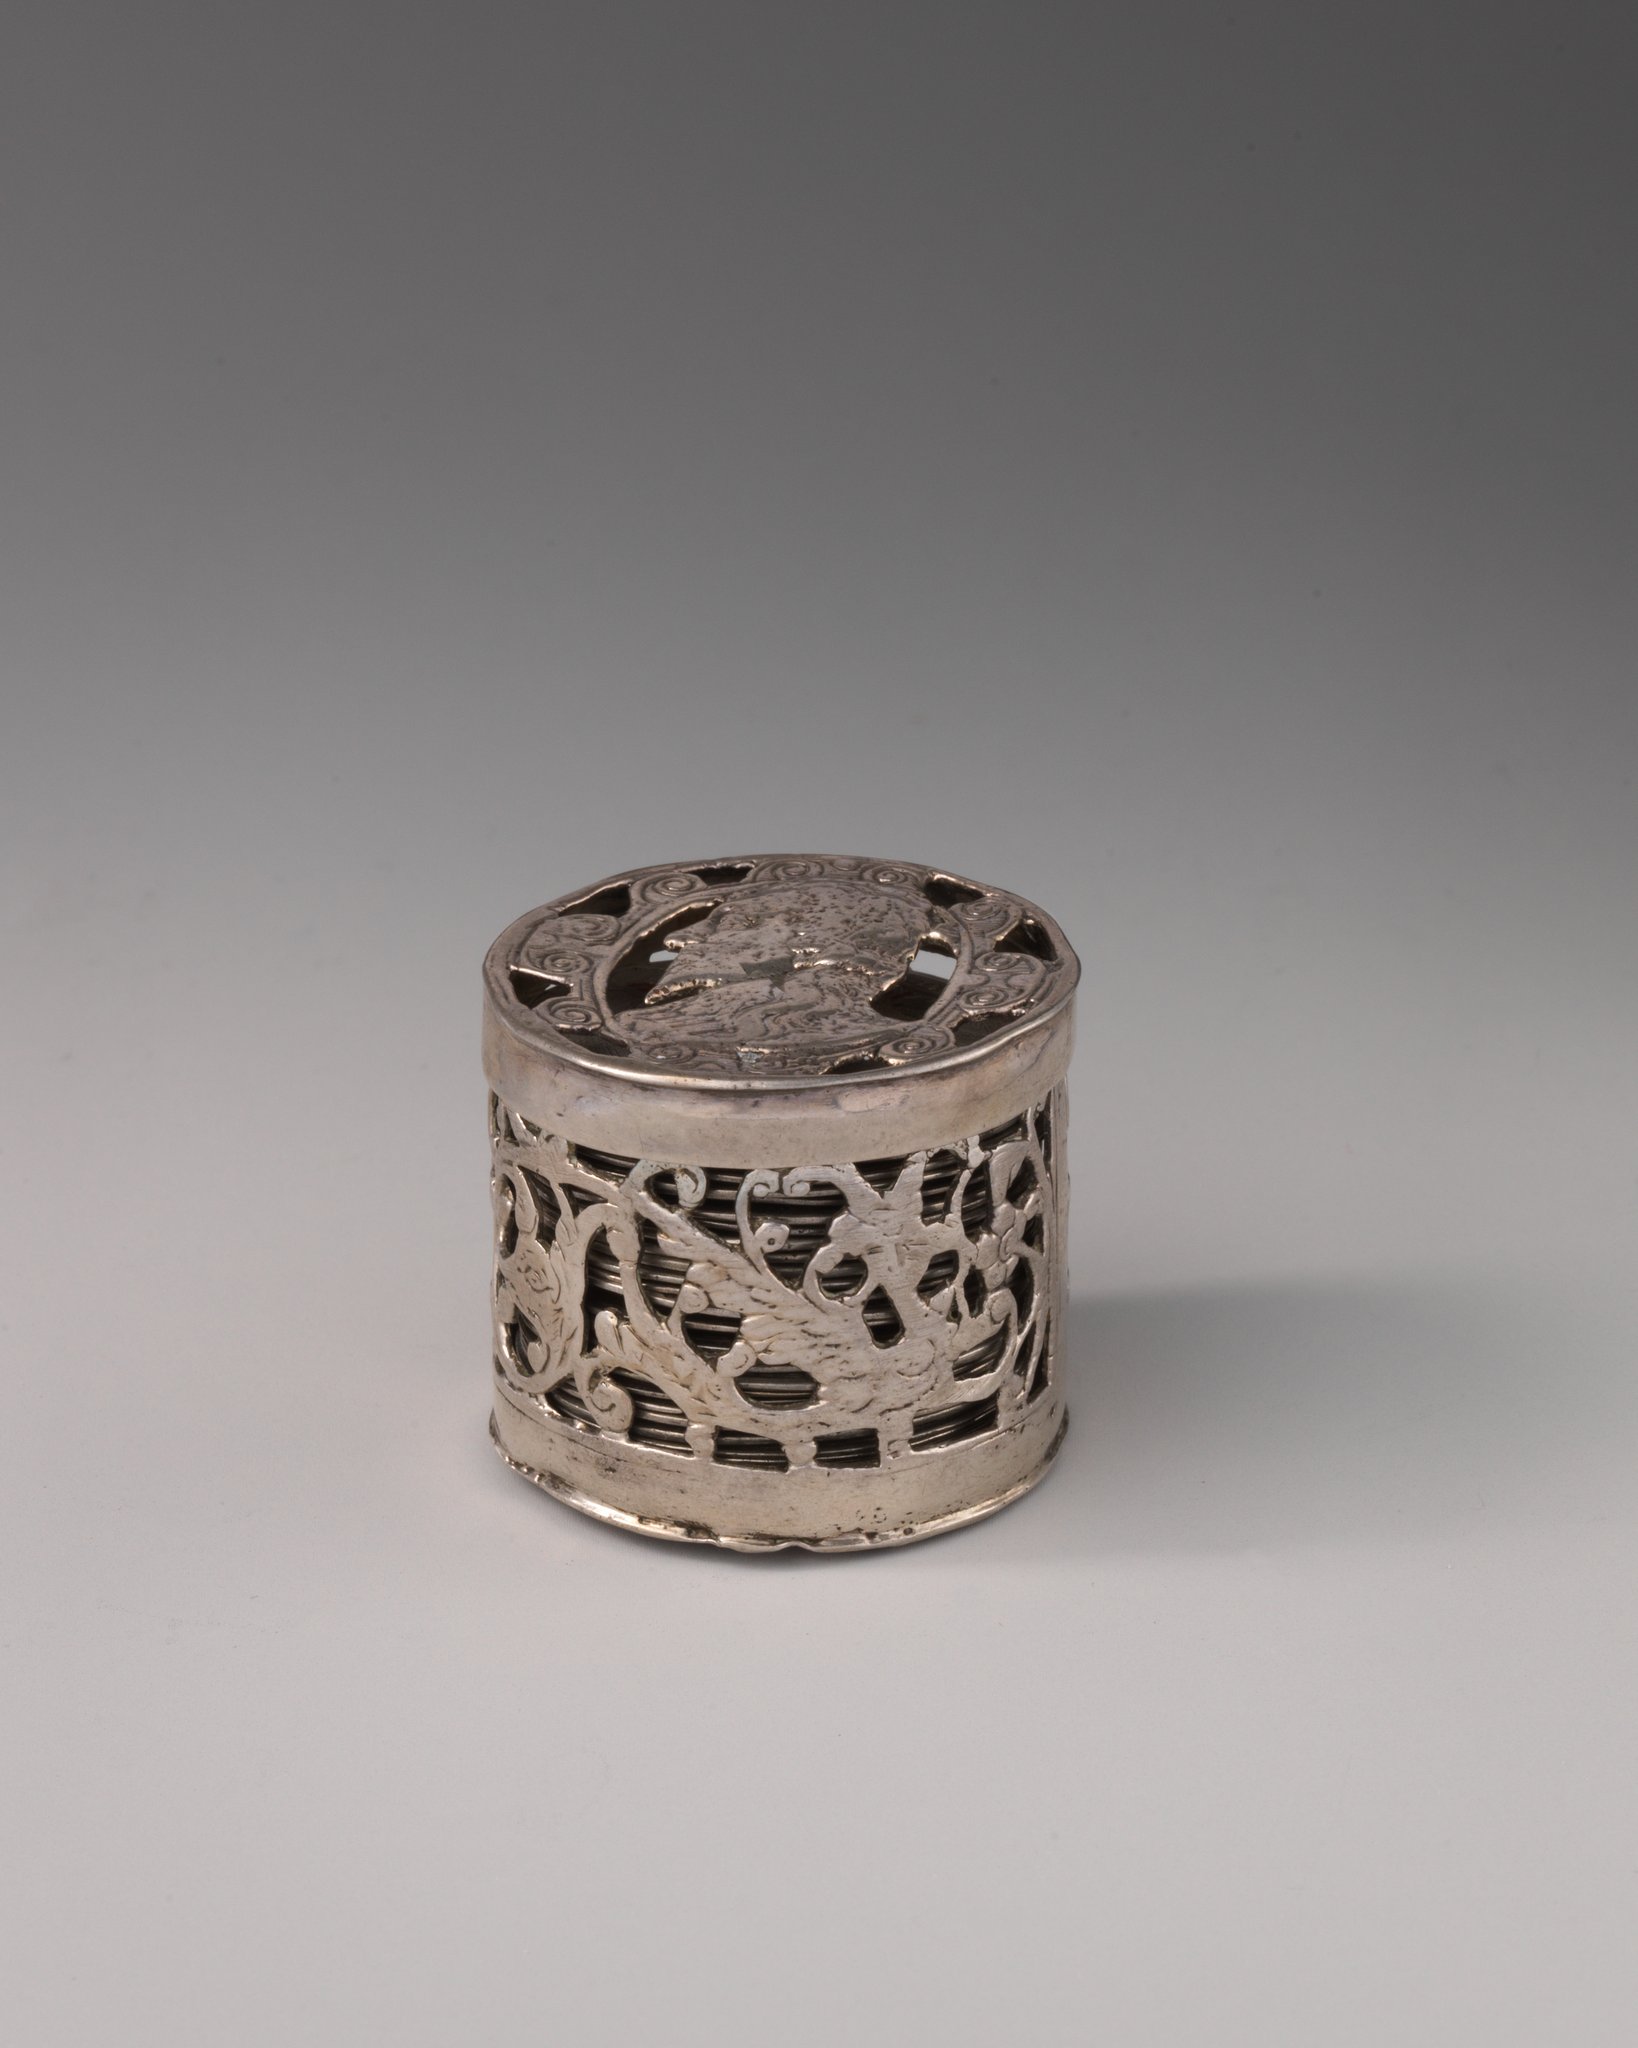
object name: counter box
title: Counter box with thirty-two counters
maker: willem de passe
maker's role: designer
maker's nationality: dutch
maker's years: 1592-1641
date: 1632-1649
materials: silver